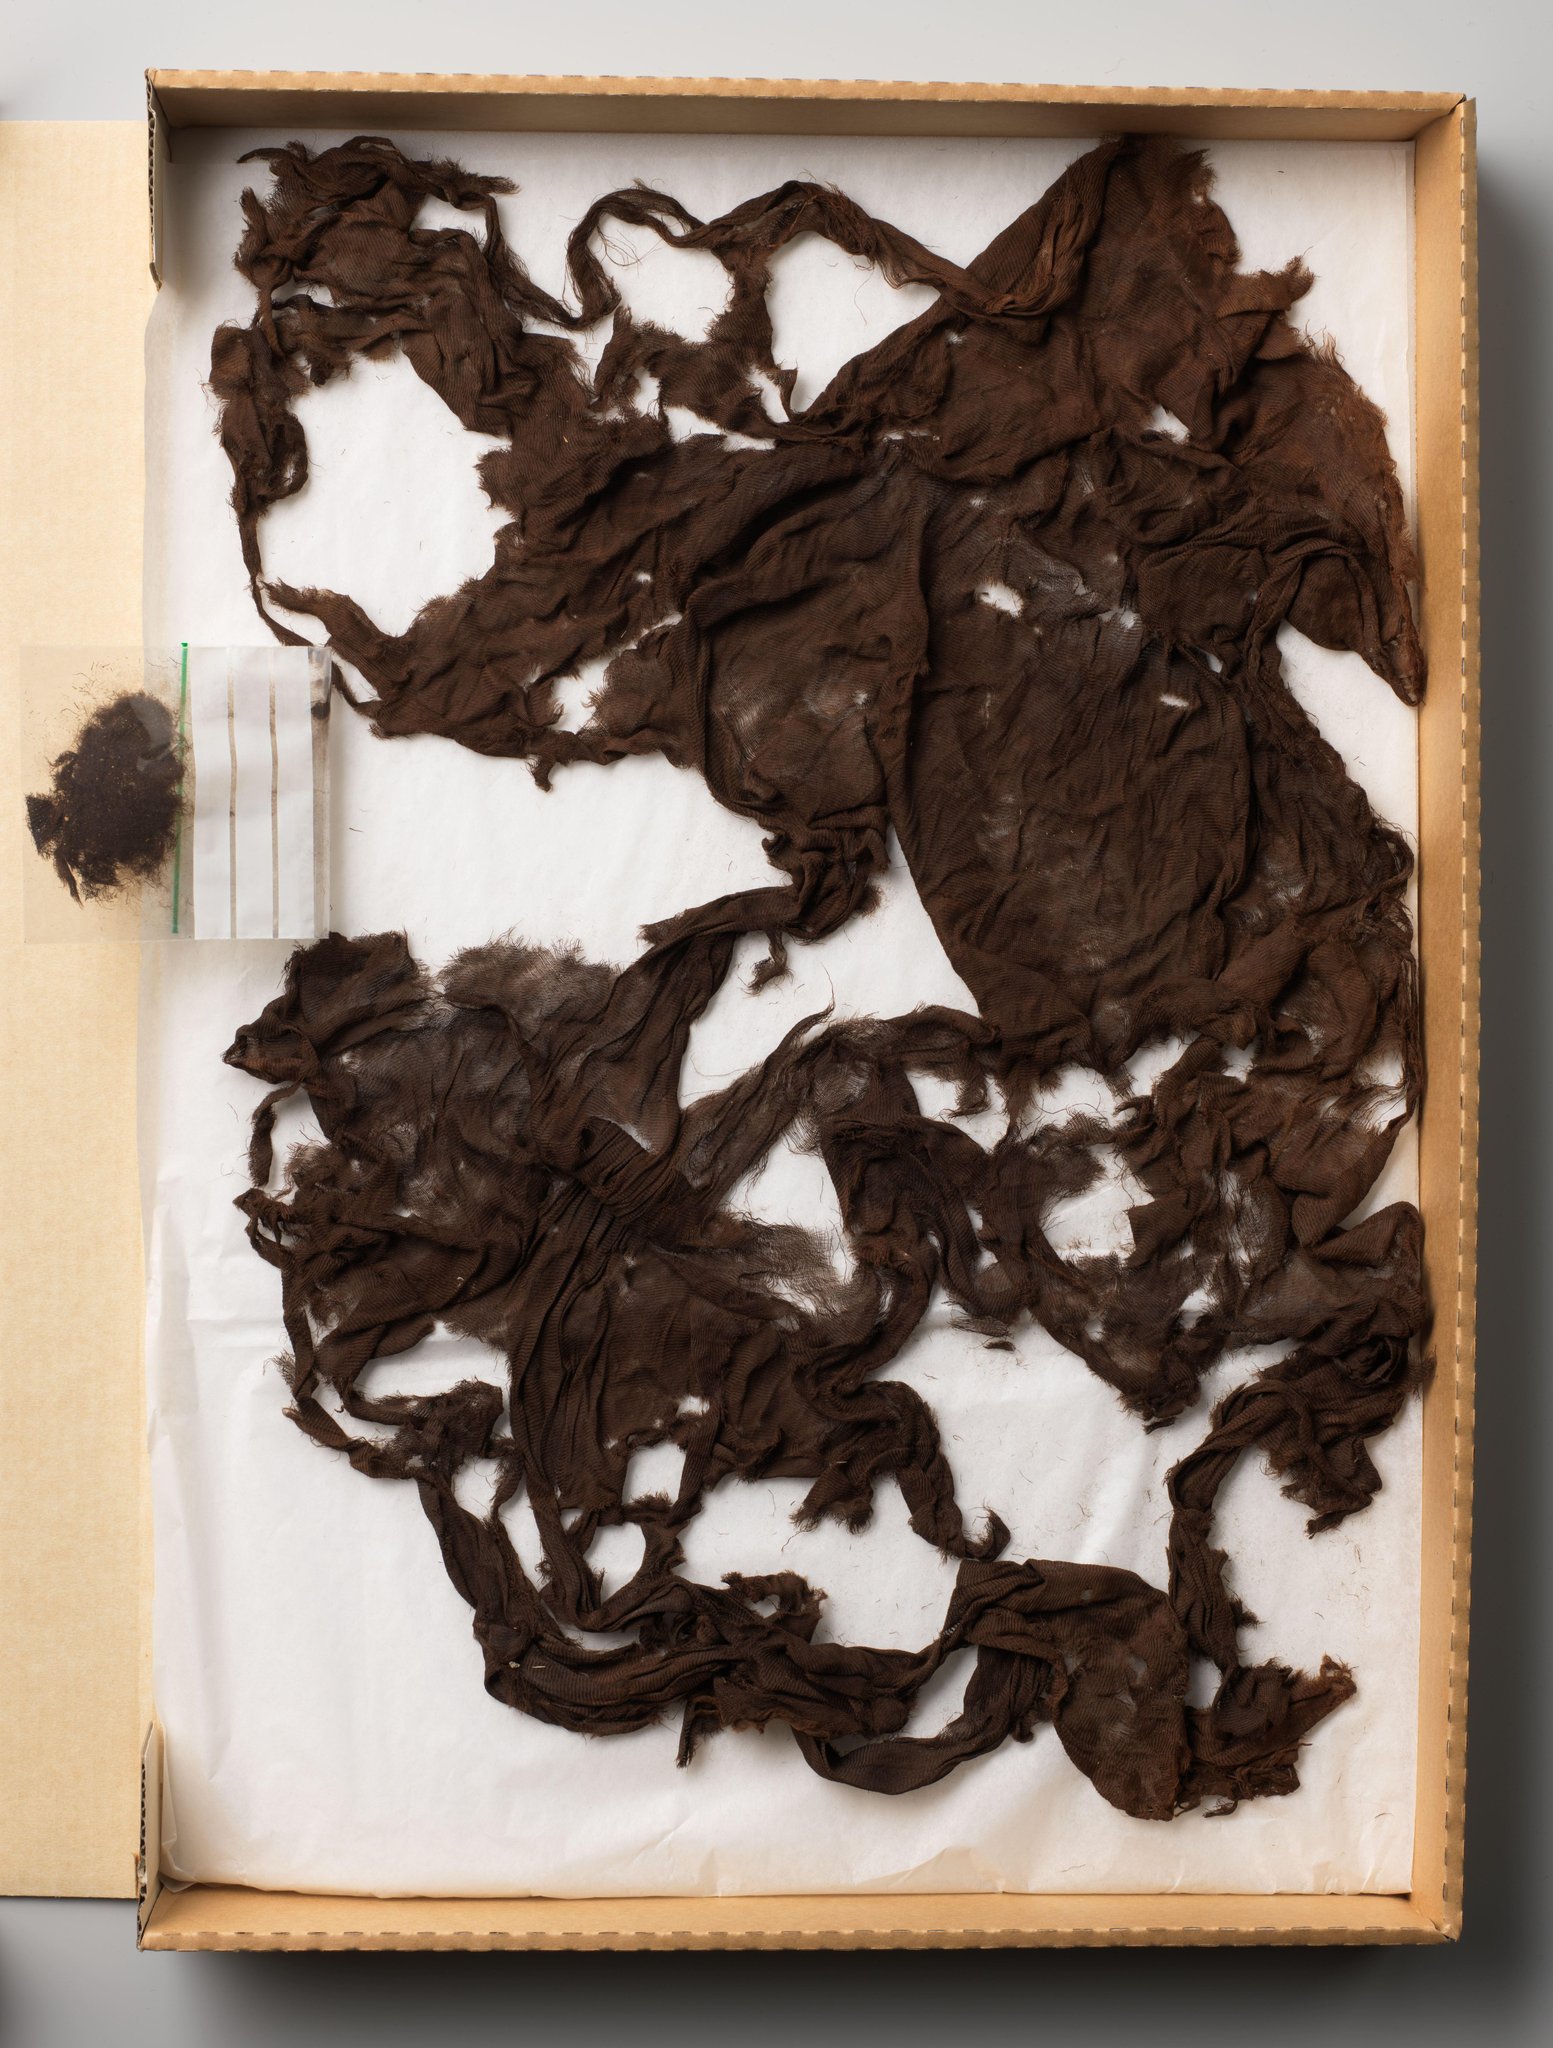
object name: cloth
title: Blinddoek gedragen bij de executie van freule Johanna Magdalena Catharina Judith van Dorth tot Holthuysen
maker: Anonymous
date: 1799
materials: silk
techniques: sewing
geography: netherlands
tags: johanna magdalena catharina judith van dorth, winterswijk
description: Gedragen door freule Judith van Dorth tot Holthuysen, stiftsjuffer te Grevelsberg, bij haar executie te Winterswijk, 24 november 1799 's morgens tussen tien en elf uur. Zij werd ter dood veroordeeld door de krijgsraad, opgericht door de fransman Girod, wegens haar geuite sympathieën voor Oranje. Deze doek was met een dubbele knoop om de door kogelgaten doorboorde schedel gebonden. Afkomstig uit het graf van de freule in de N.H. kerk te Lichtenvoorde. De schoenen werden aangetroffen in 1929 toen bij een verbouwing van de kerk van Lichtervoorde het graf van Freule Judith van Dorth tot Holthuizen werd gevonden. Zij bleef in de Franse Tijd openlijk loyaal aan de Oranjes, en werd in 1799 door de Patriotten gearresteerd, berecht en geexecuteerd. Het lichaam is vervolgens herbegraven; haar schoenen en de blinddoek die ze droeg zijn echter bewaard.